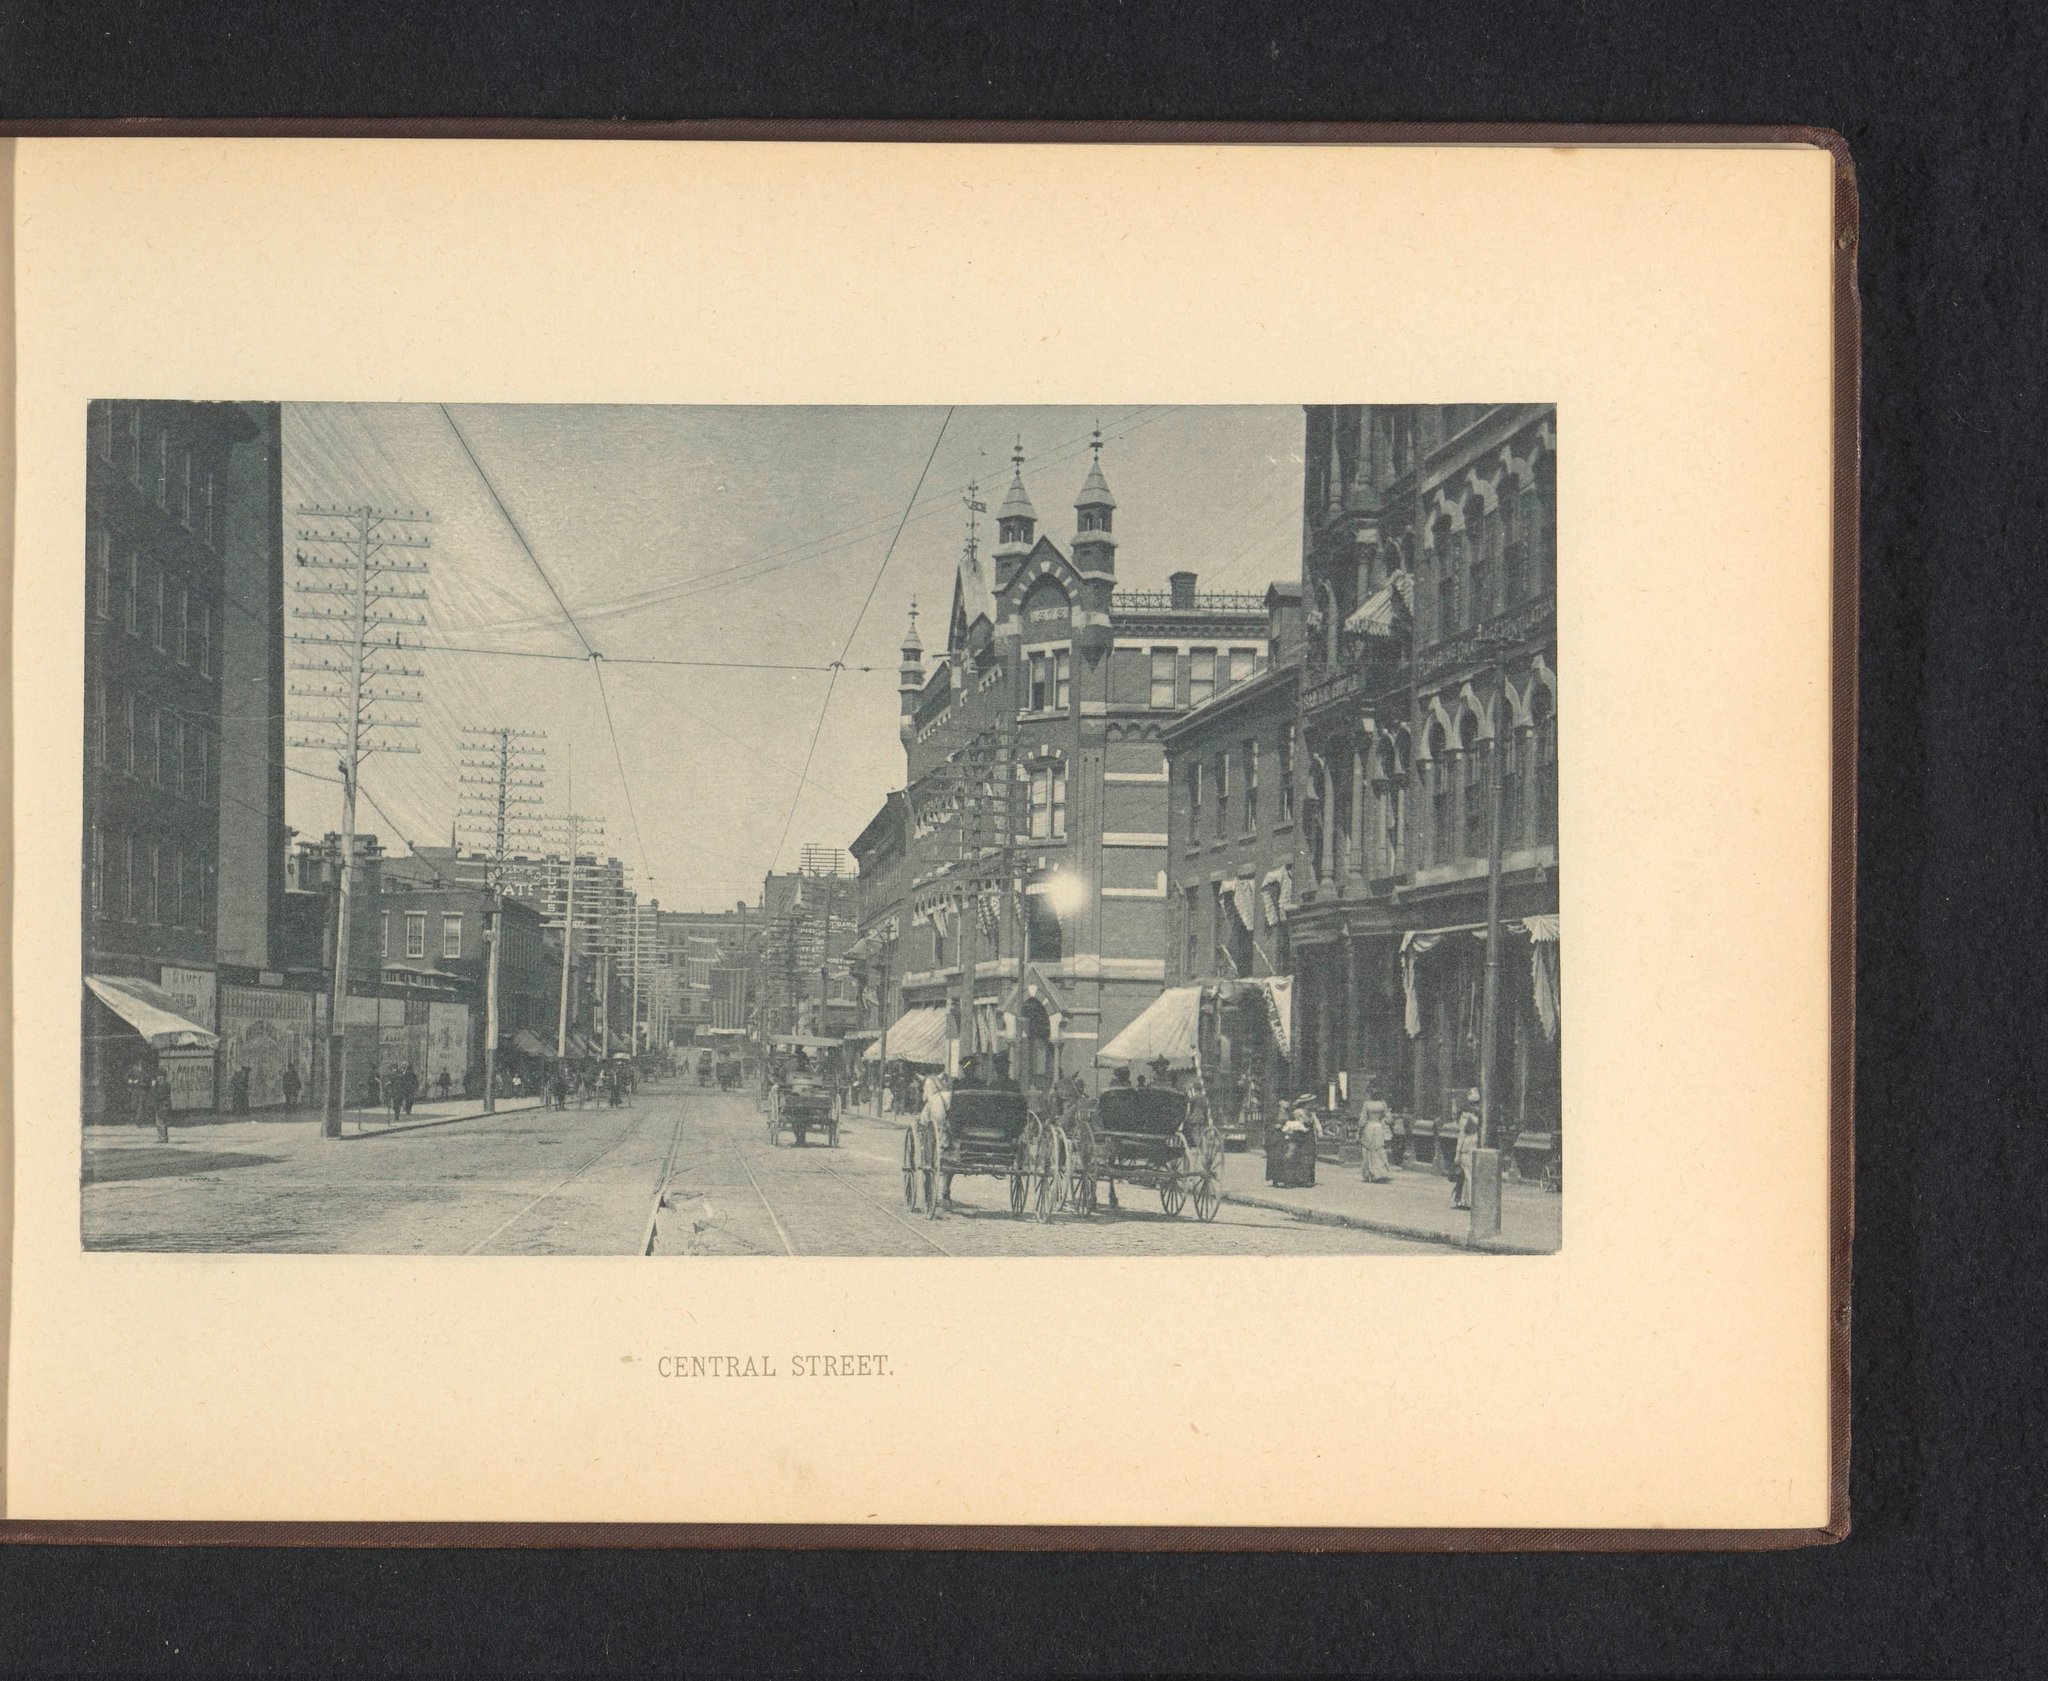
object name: page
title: Central street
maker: Anonymous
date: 1887-1892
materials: paper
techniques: photograph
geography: lowell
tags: city-view in general; 'veduta', street